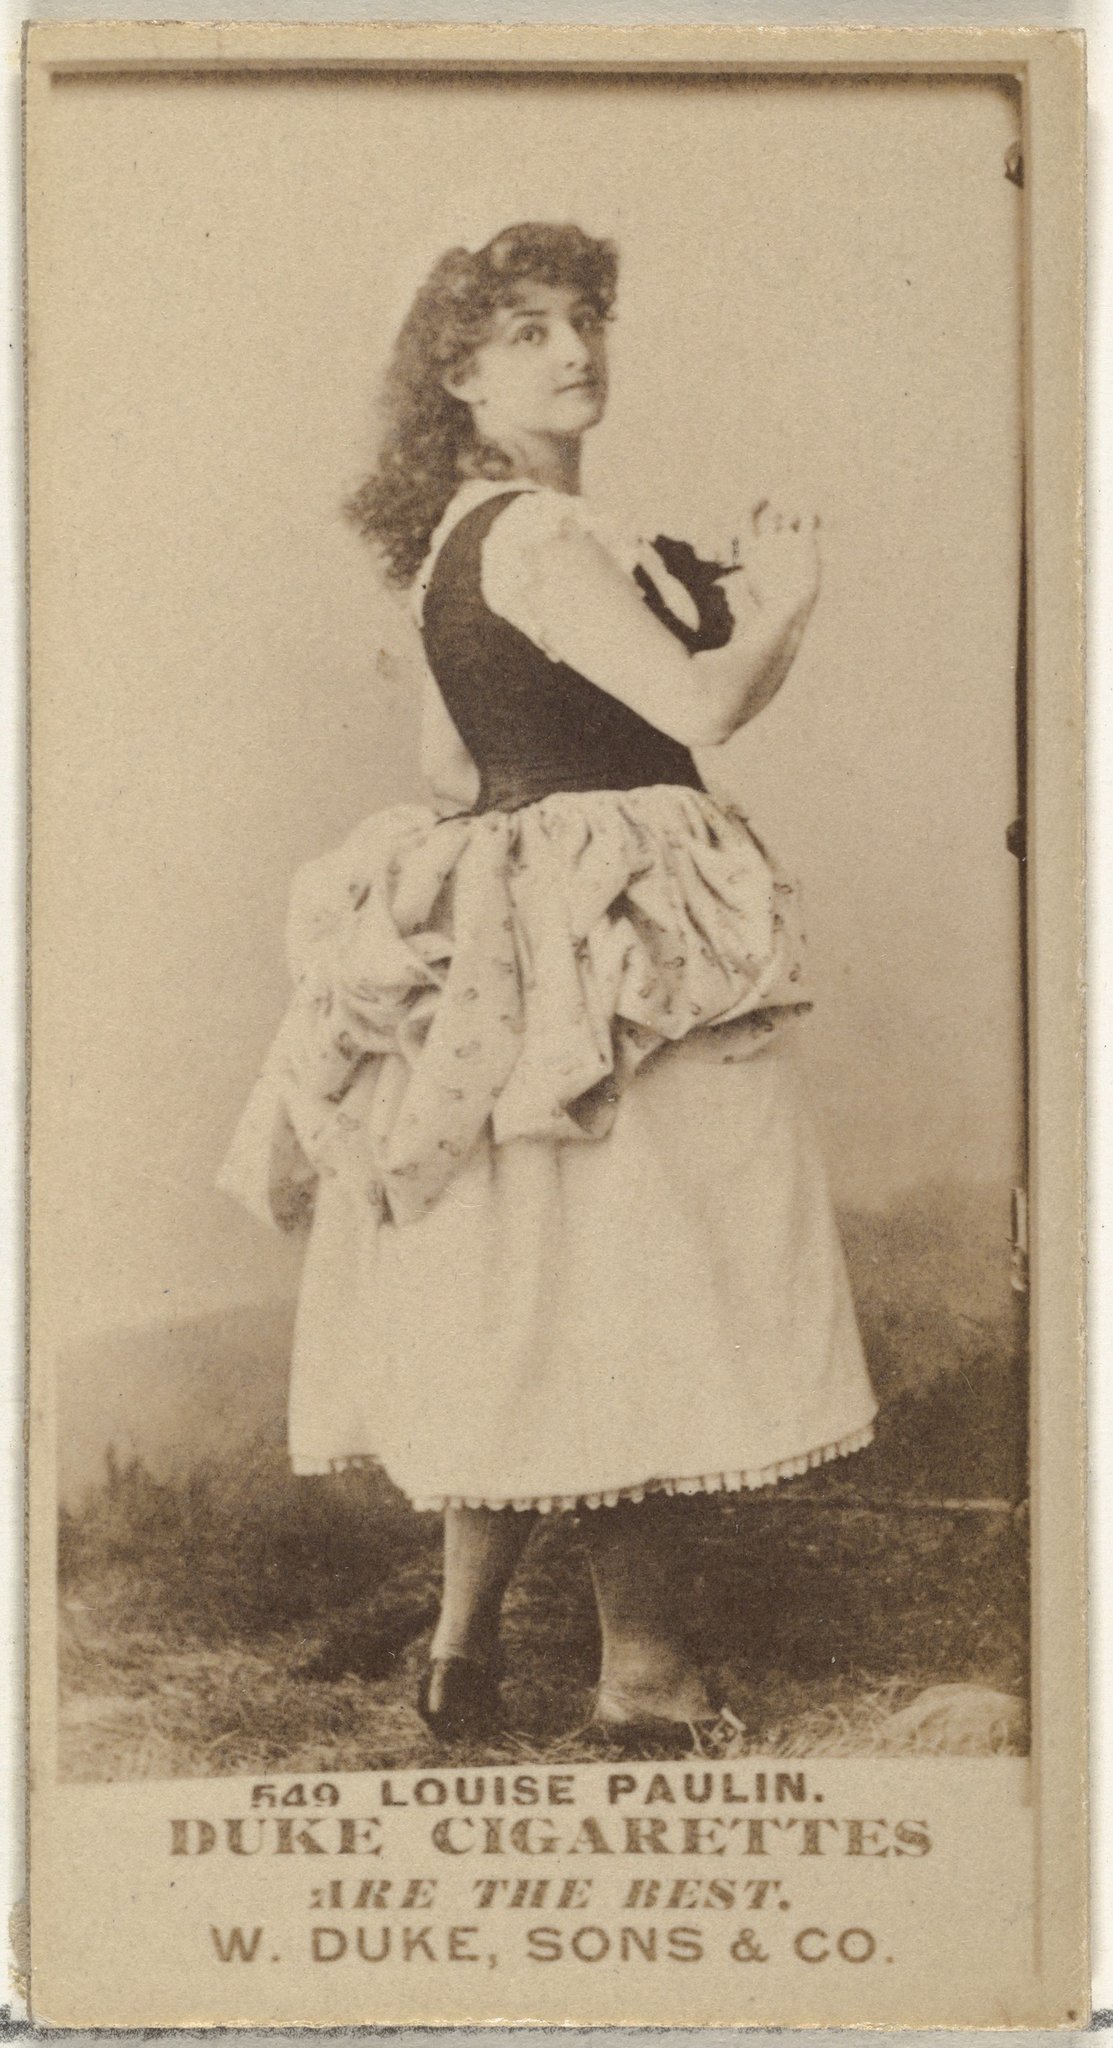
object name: photograph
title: Card Number 649, Louise Paulin, from the Actors and Actresses series (N145-7) issued by Duke Sons & Co. to promote Duke Cigarettes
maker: w. duke, sons & co.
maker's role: publisher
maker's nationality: american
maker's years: 1870-1920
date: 1880-1889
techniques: albumen silver print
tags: portraits,women,actresses